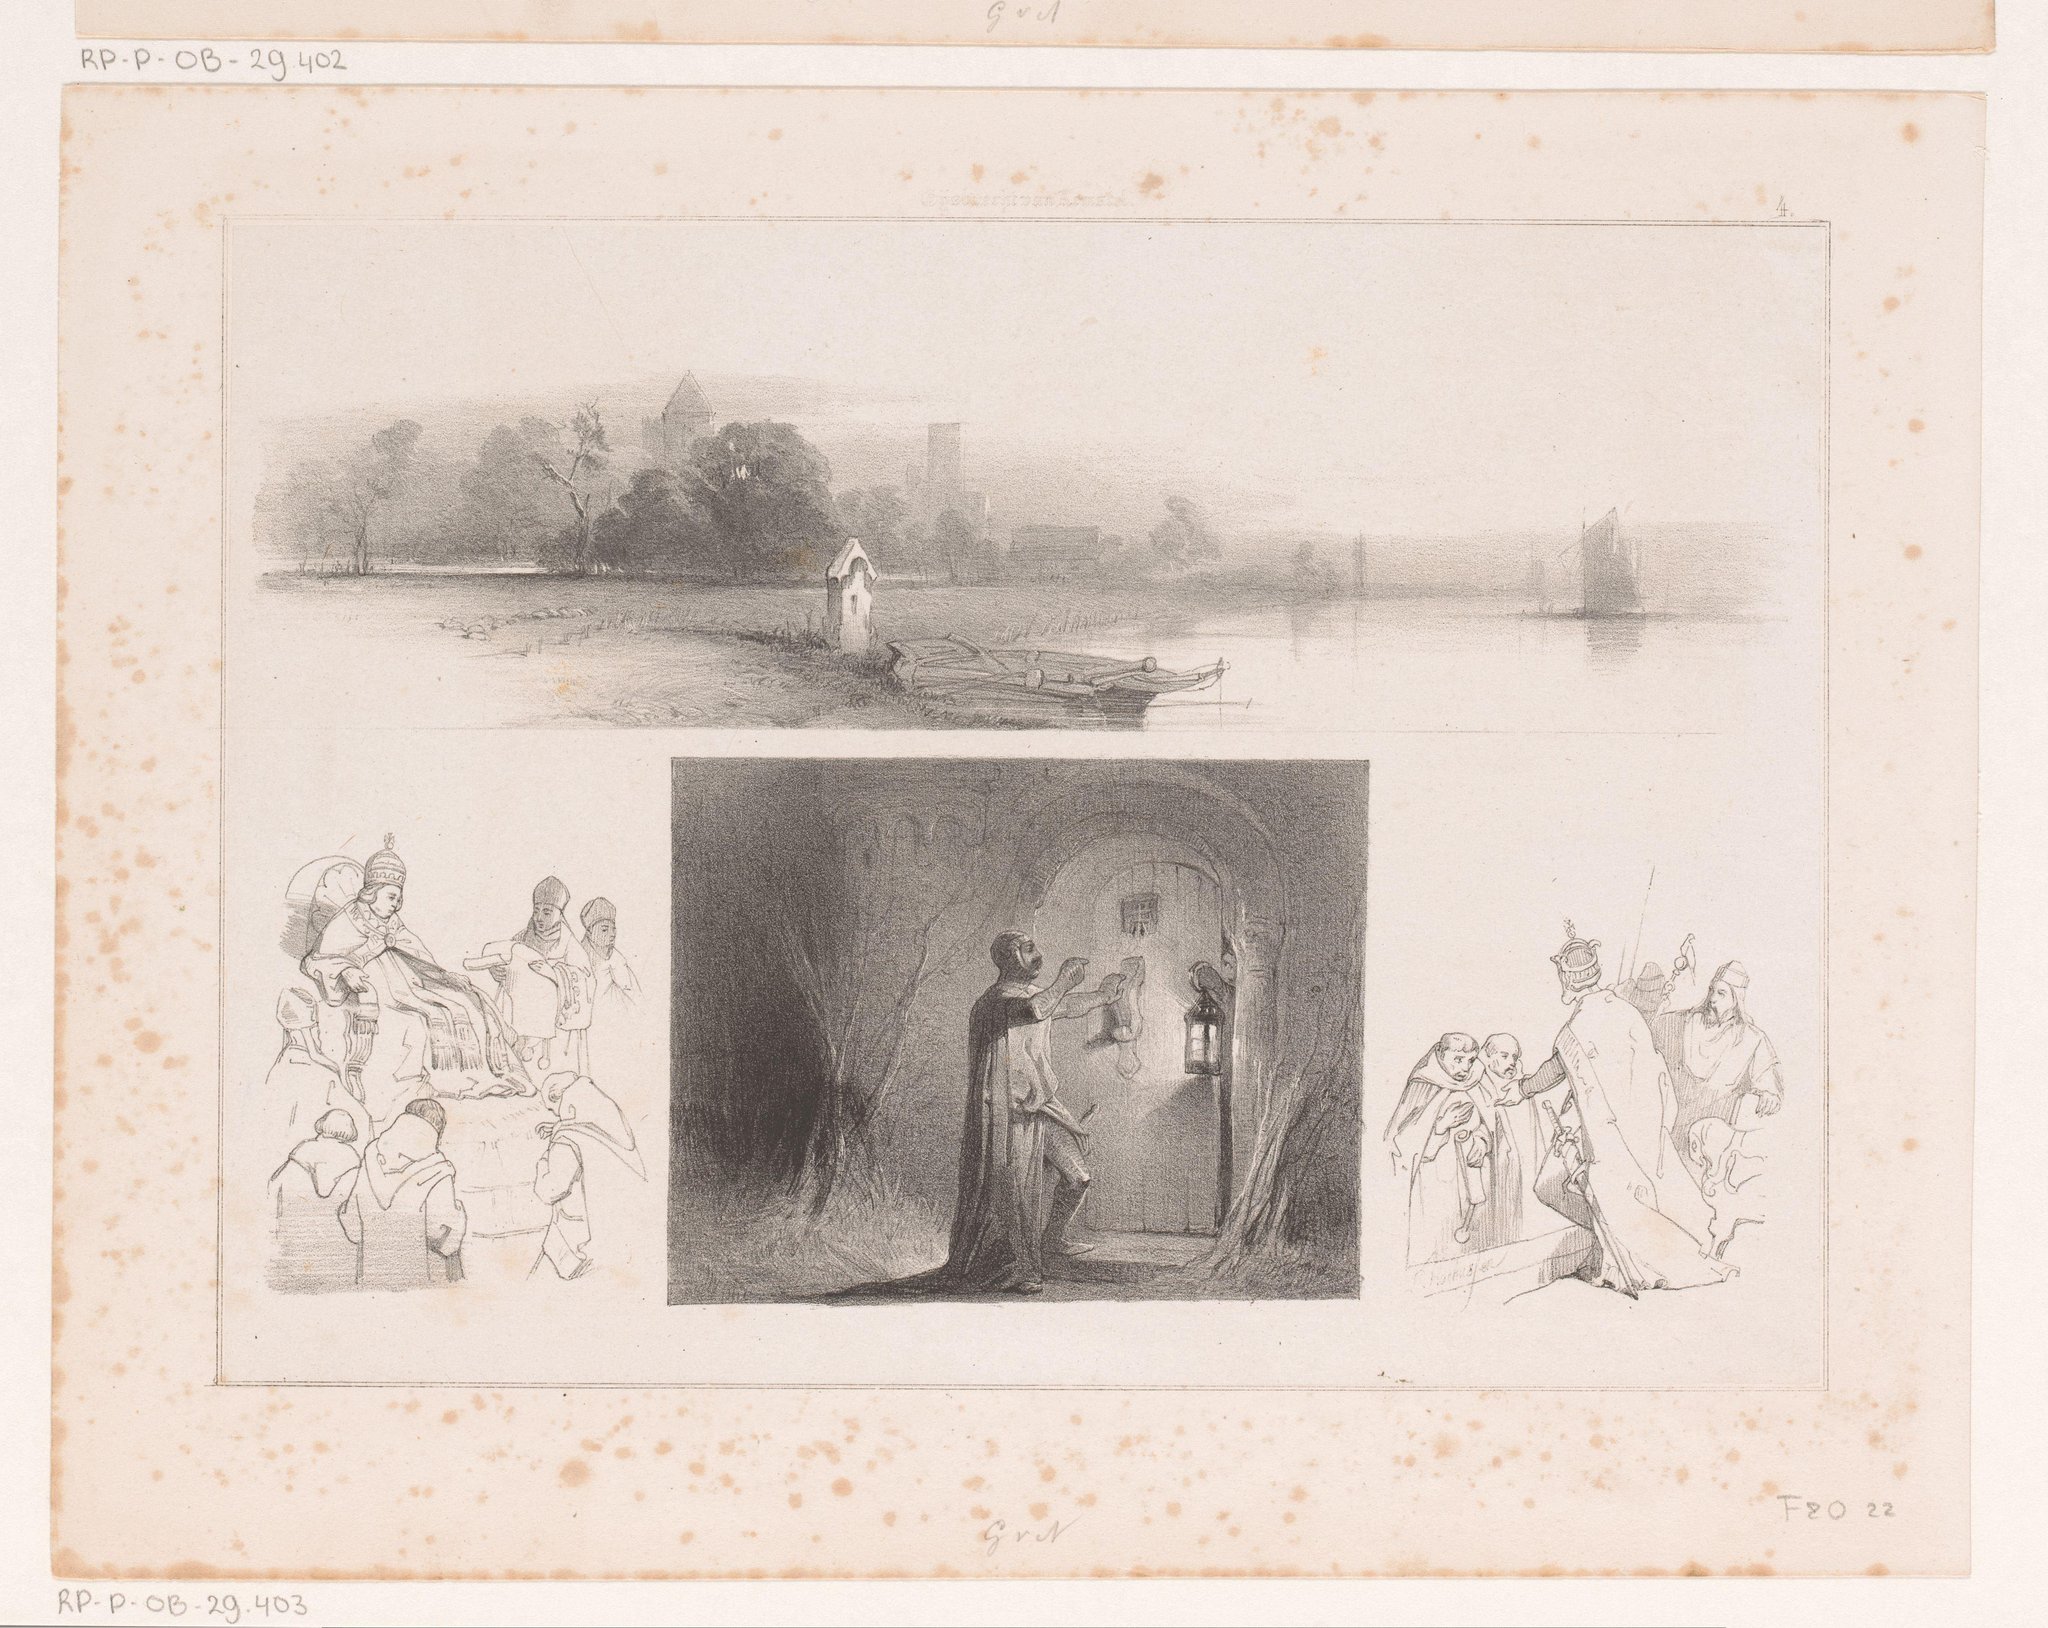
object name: book illustration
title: Ridder voor geopende deur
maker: charles rochussen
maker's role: draughtsman, painter, print maker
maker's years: 1814-1894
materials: paper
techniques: lithograph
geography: the hague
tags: open door, monk(s), friar(s)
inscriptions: collector's mark: Lugt 2228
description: Een ridder staat voor een op een kier geopende deur. De man achter de deur steekt een brandende lantaarn naar buiten. Rondom diverse scènes met een lege boot op het water, een paus en ander religieuzen.